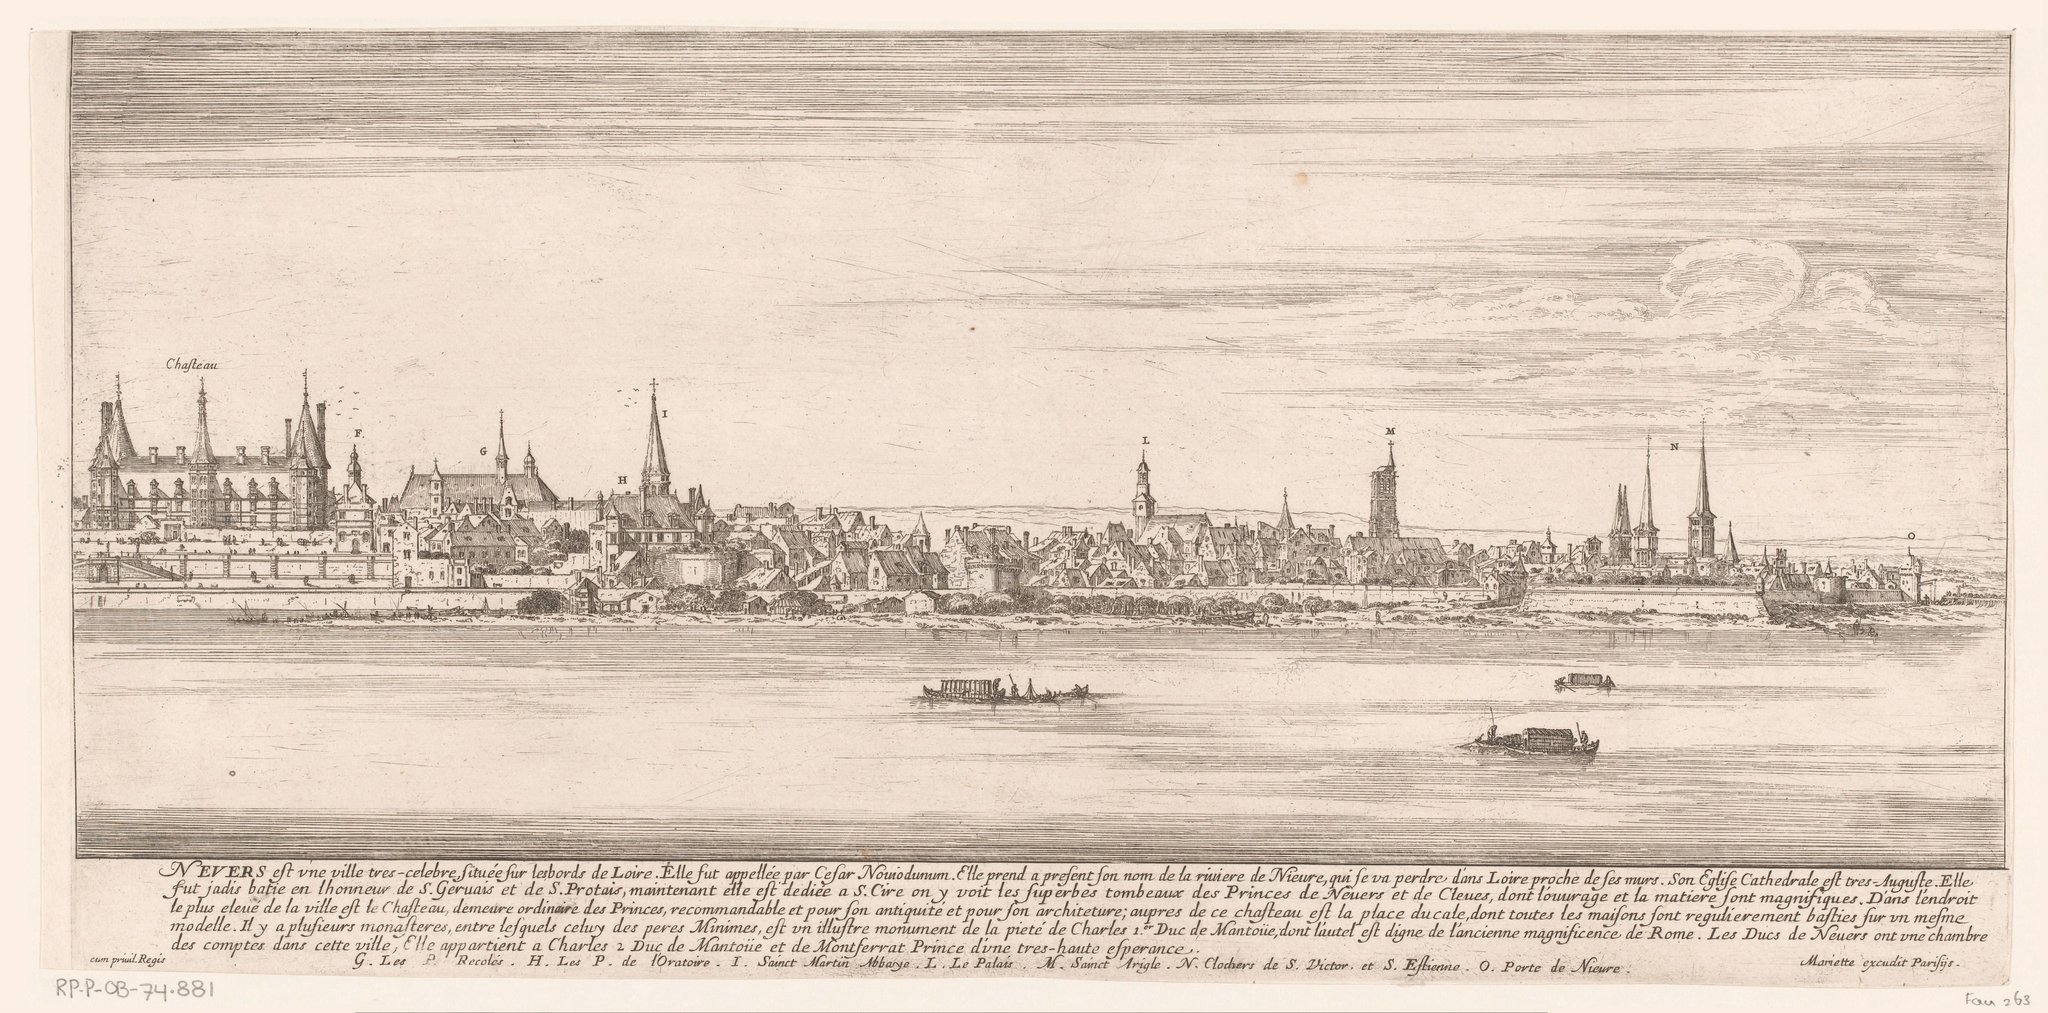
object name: print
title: Profiel van de stad Nevers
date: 1631-1691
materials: paper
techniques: engraving, etching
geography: france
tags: city-view, and landscape with man-made constructions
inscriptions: collector's mark: Lugt 240